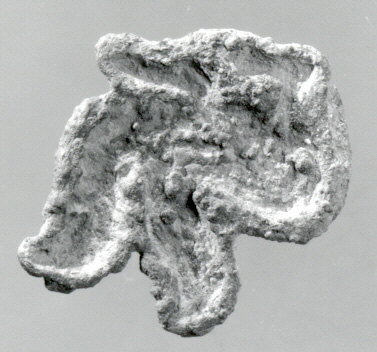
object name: stamp seal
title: Stamp seal with griffin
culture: bactria-margiana archaeological complex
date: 2333-1668 BCE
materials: copper alloy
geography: bactria-margiana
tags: griffins